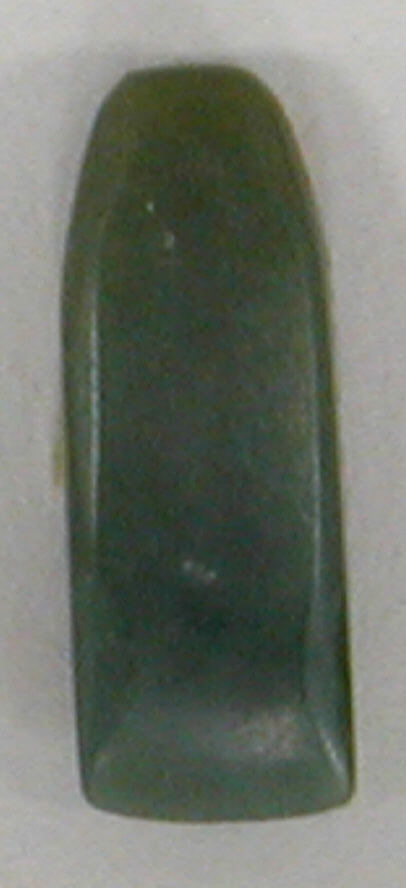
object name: celt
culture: mexican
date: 1501-1600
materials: stone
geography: mexico